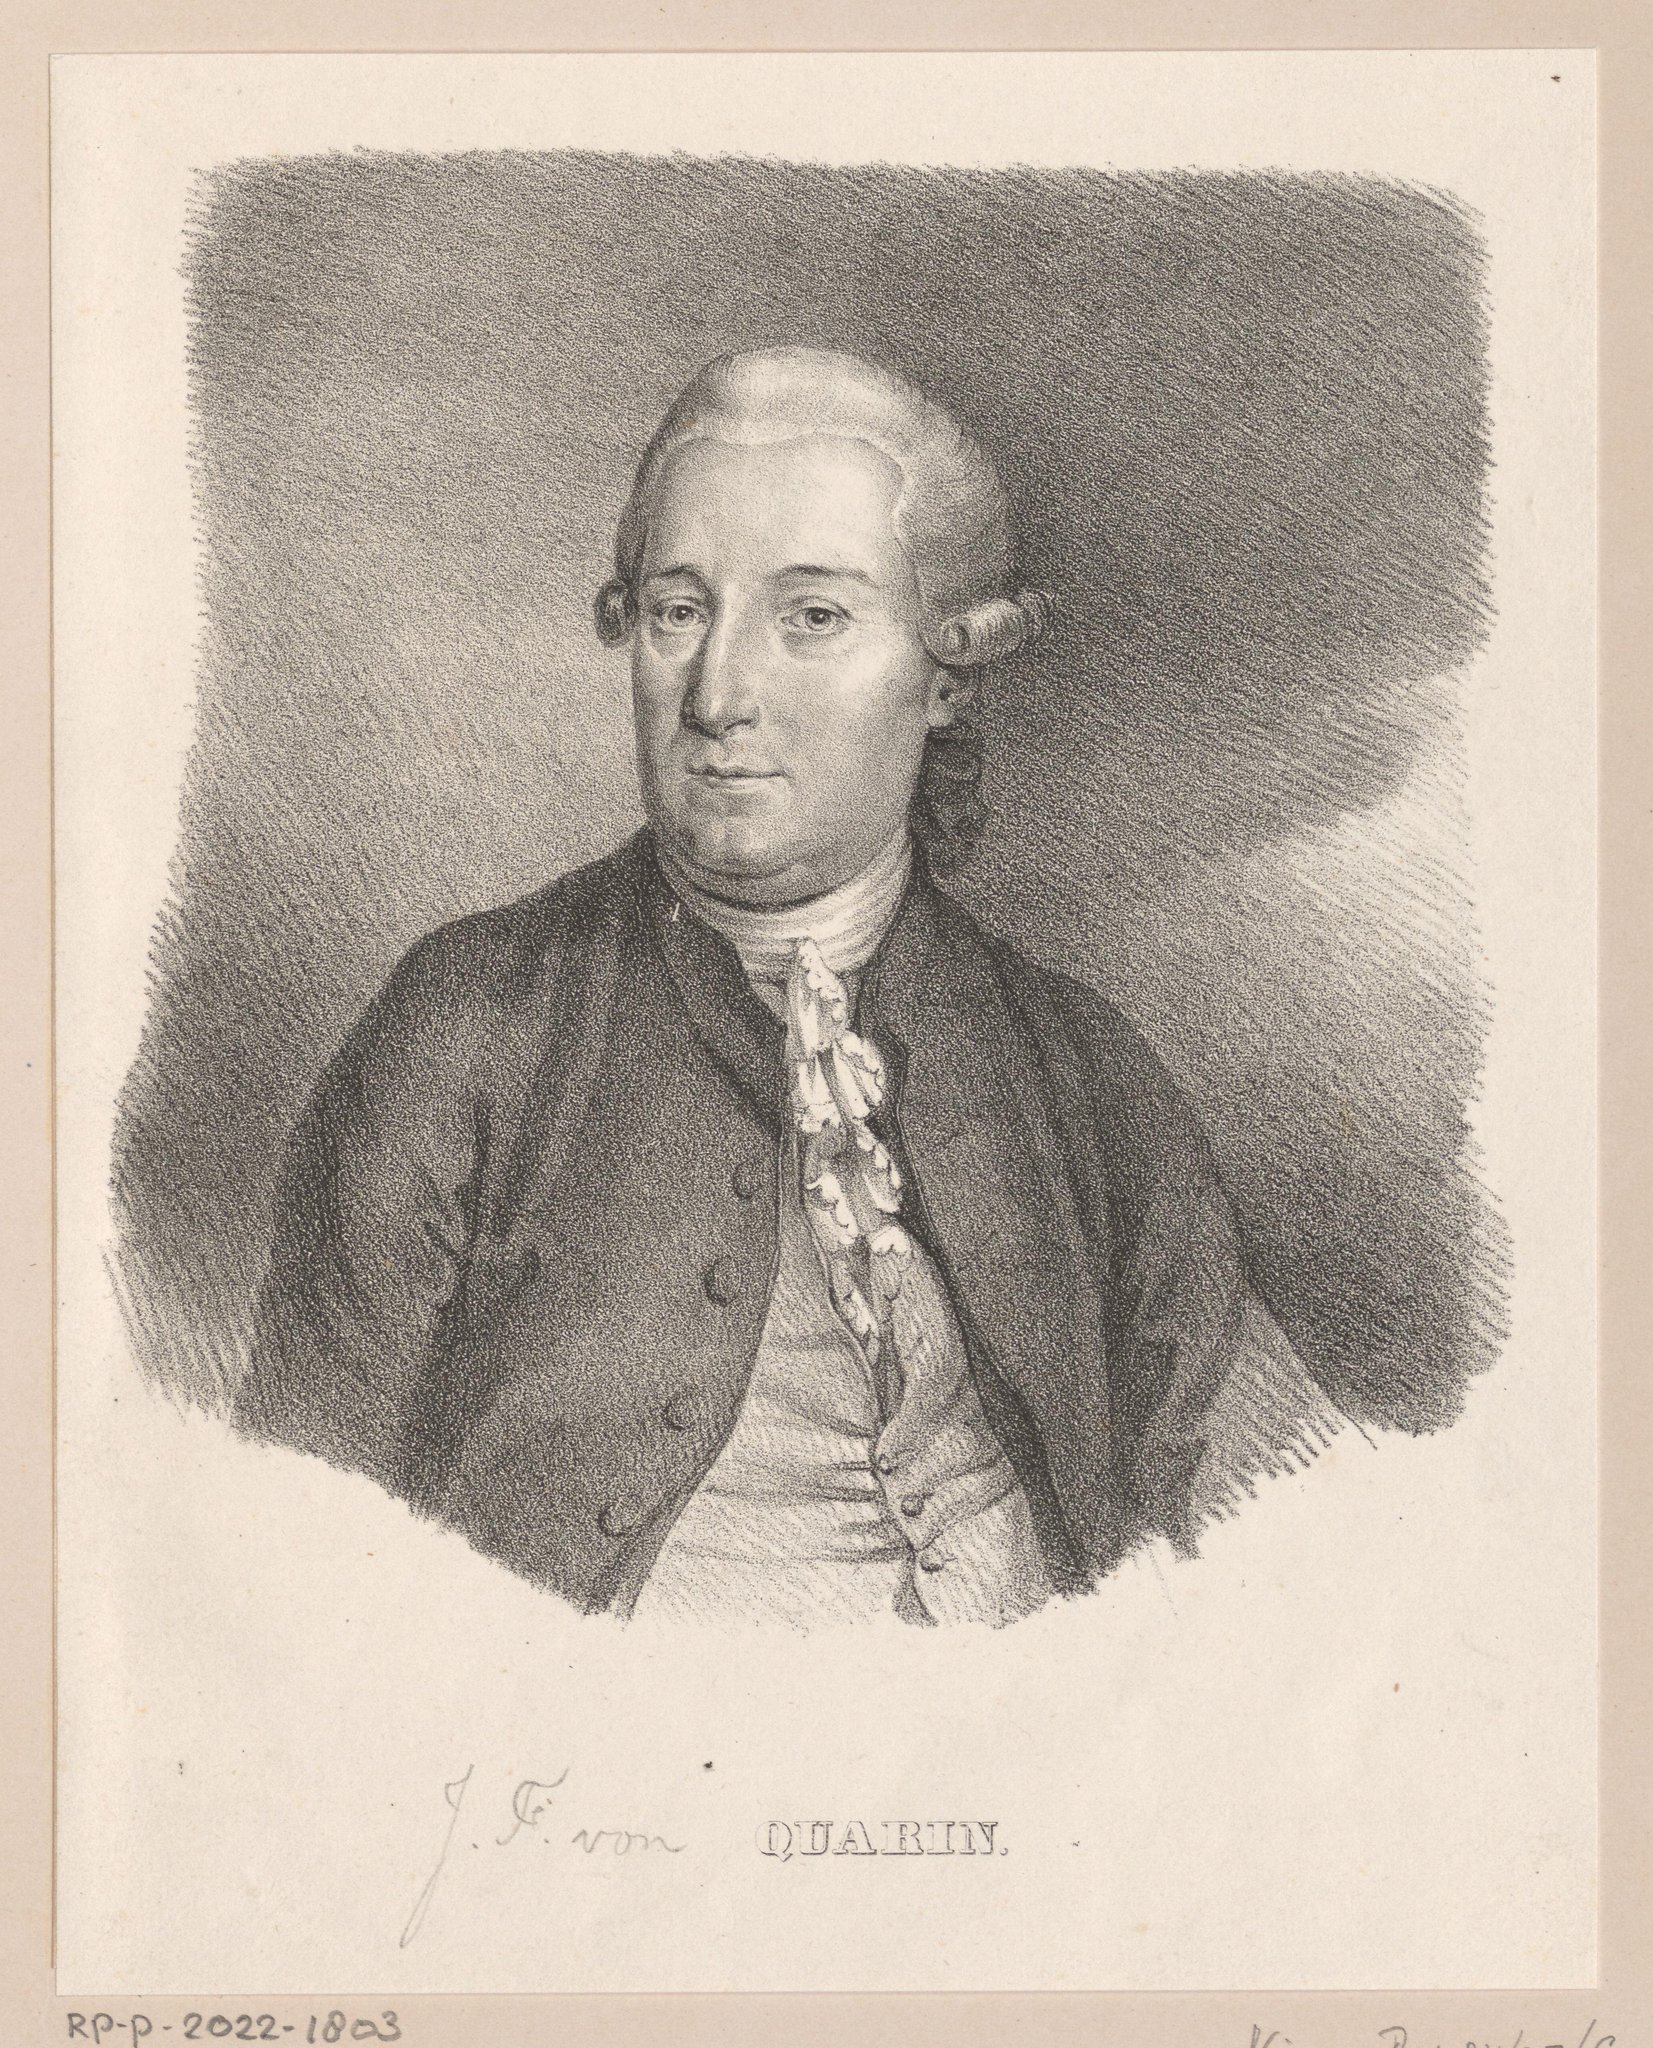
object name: print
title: Portret van Joseph von Quarin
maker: Anonymous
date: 1789-1850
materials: paper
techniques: lithograph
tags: vienna, joseph freiherr von quarin, historical persons, physician, doctor